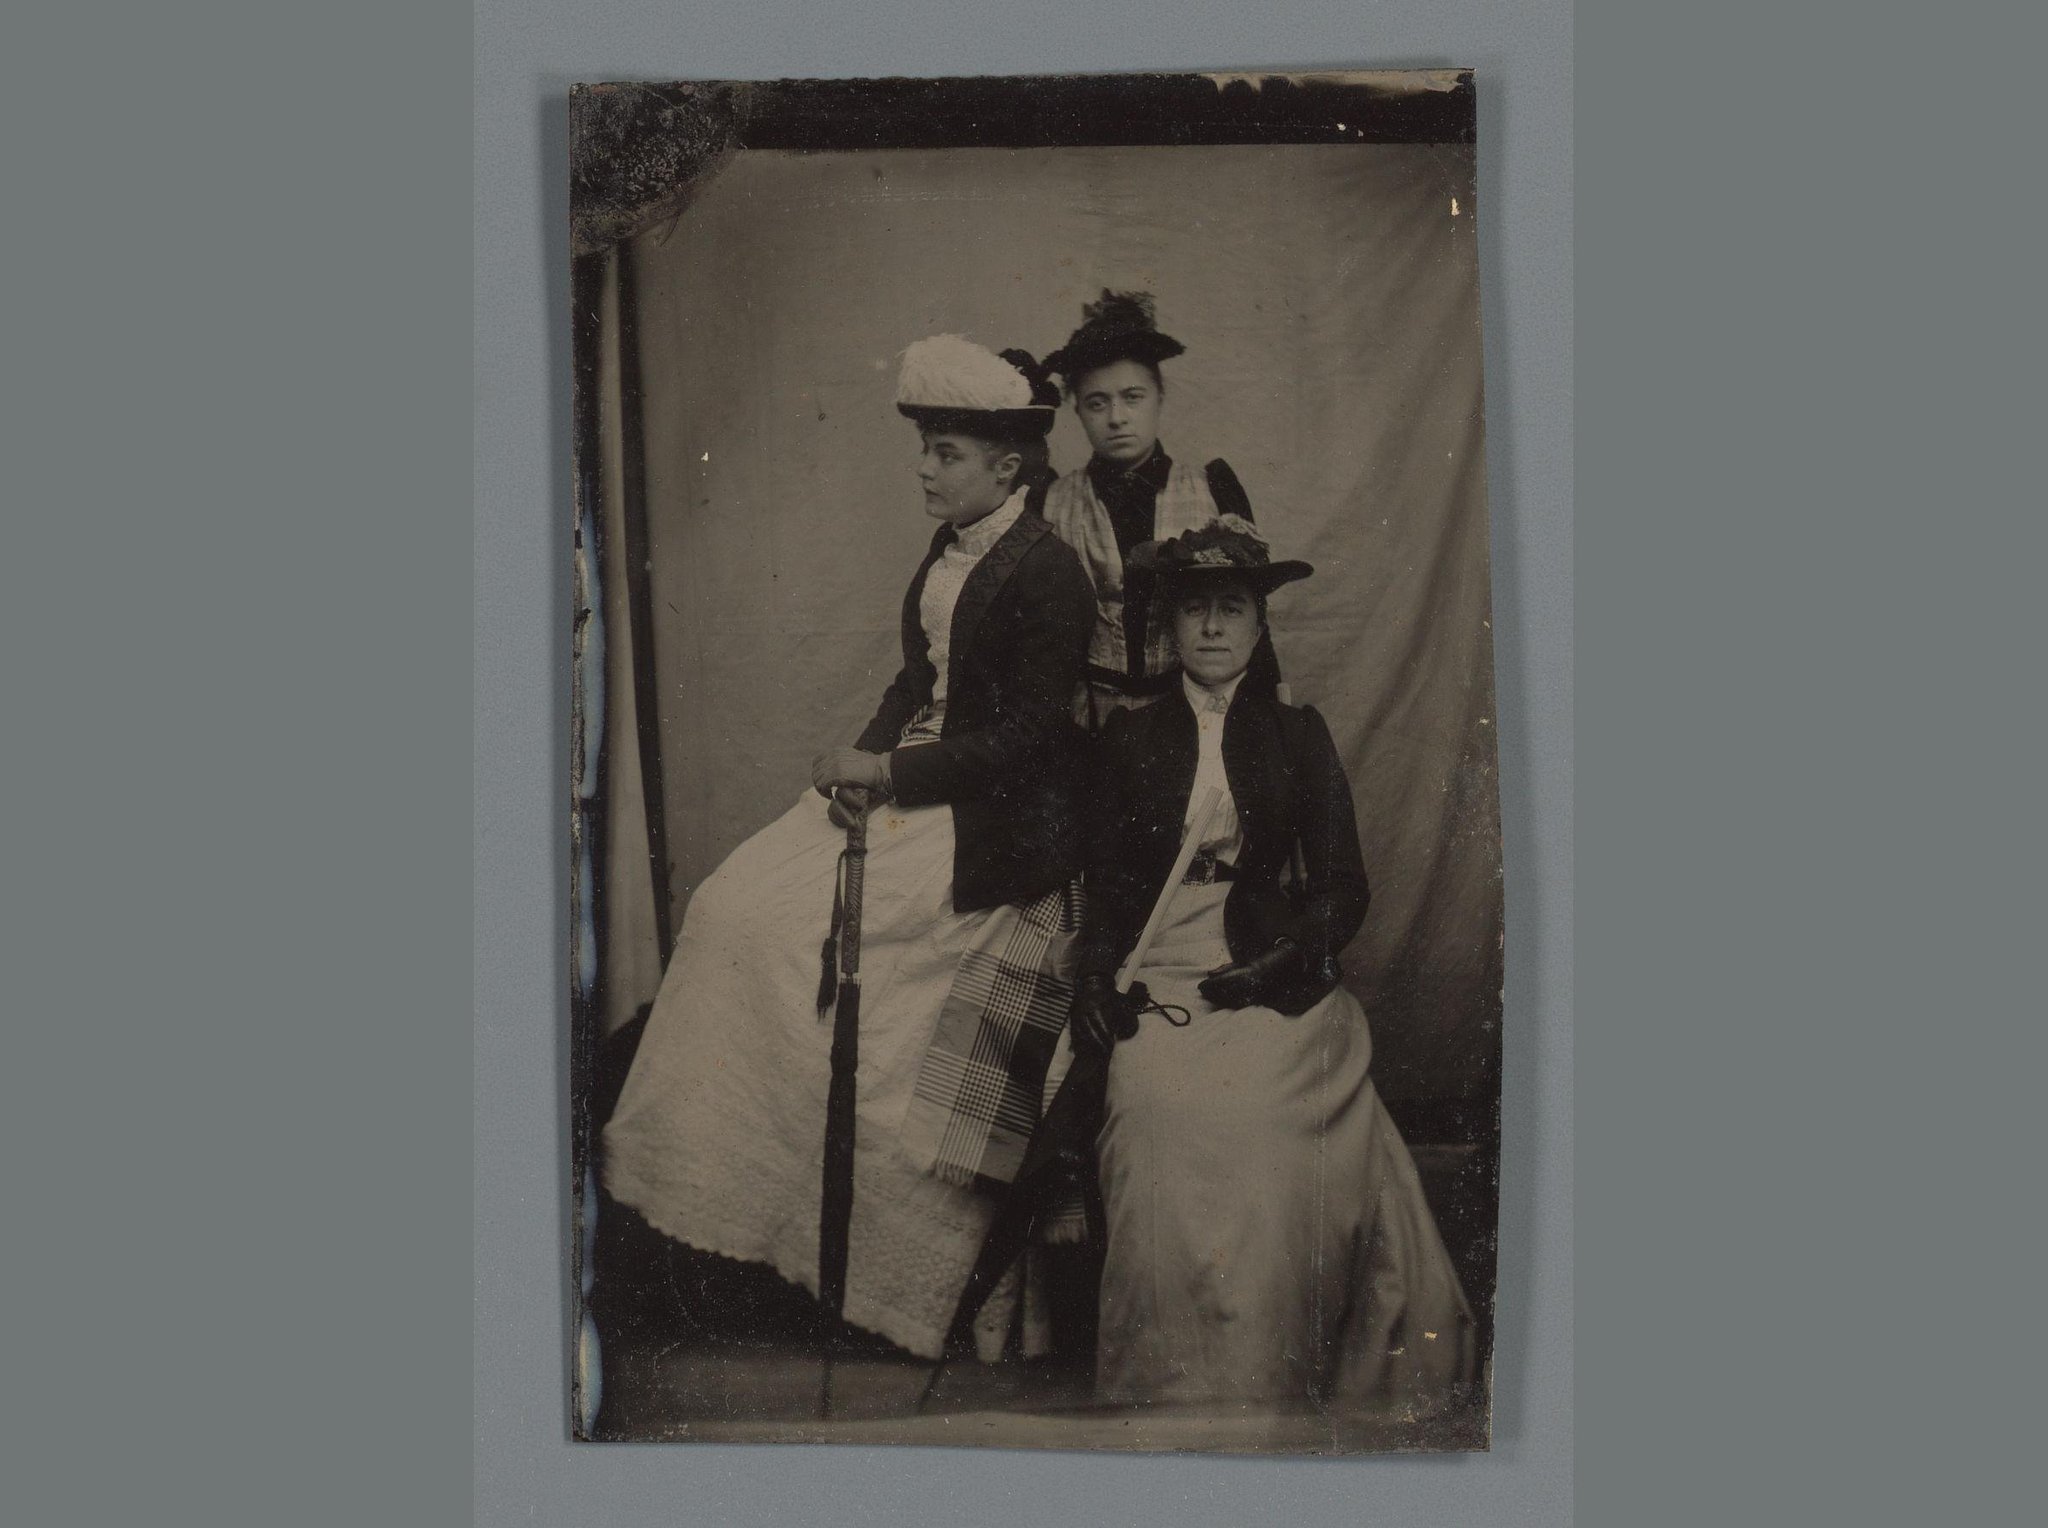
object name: photograph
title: Groepsportret met Jeanette van Tonderen, Elisabeth van Tonderen en Gerarda (Ida) van Tonderen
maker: Anonymous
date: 1895-1918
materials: iron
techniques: ferrotyping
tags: middelburg, haarlem, elisabeth de jong-van tonderen, historical persons - bb - woman